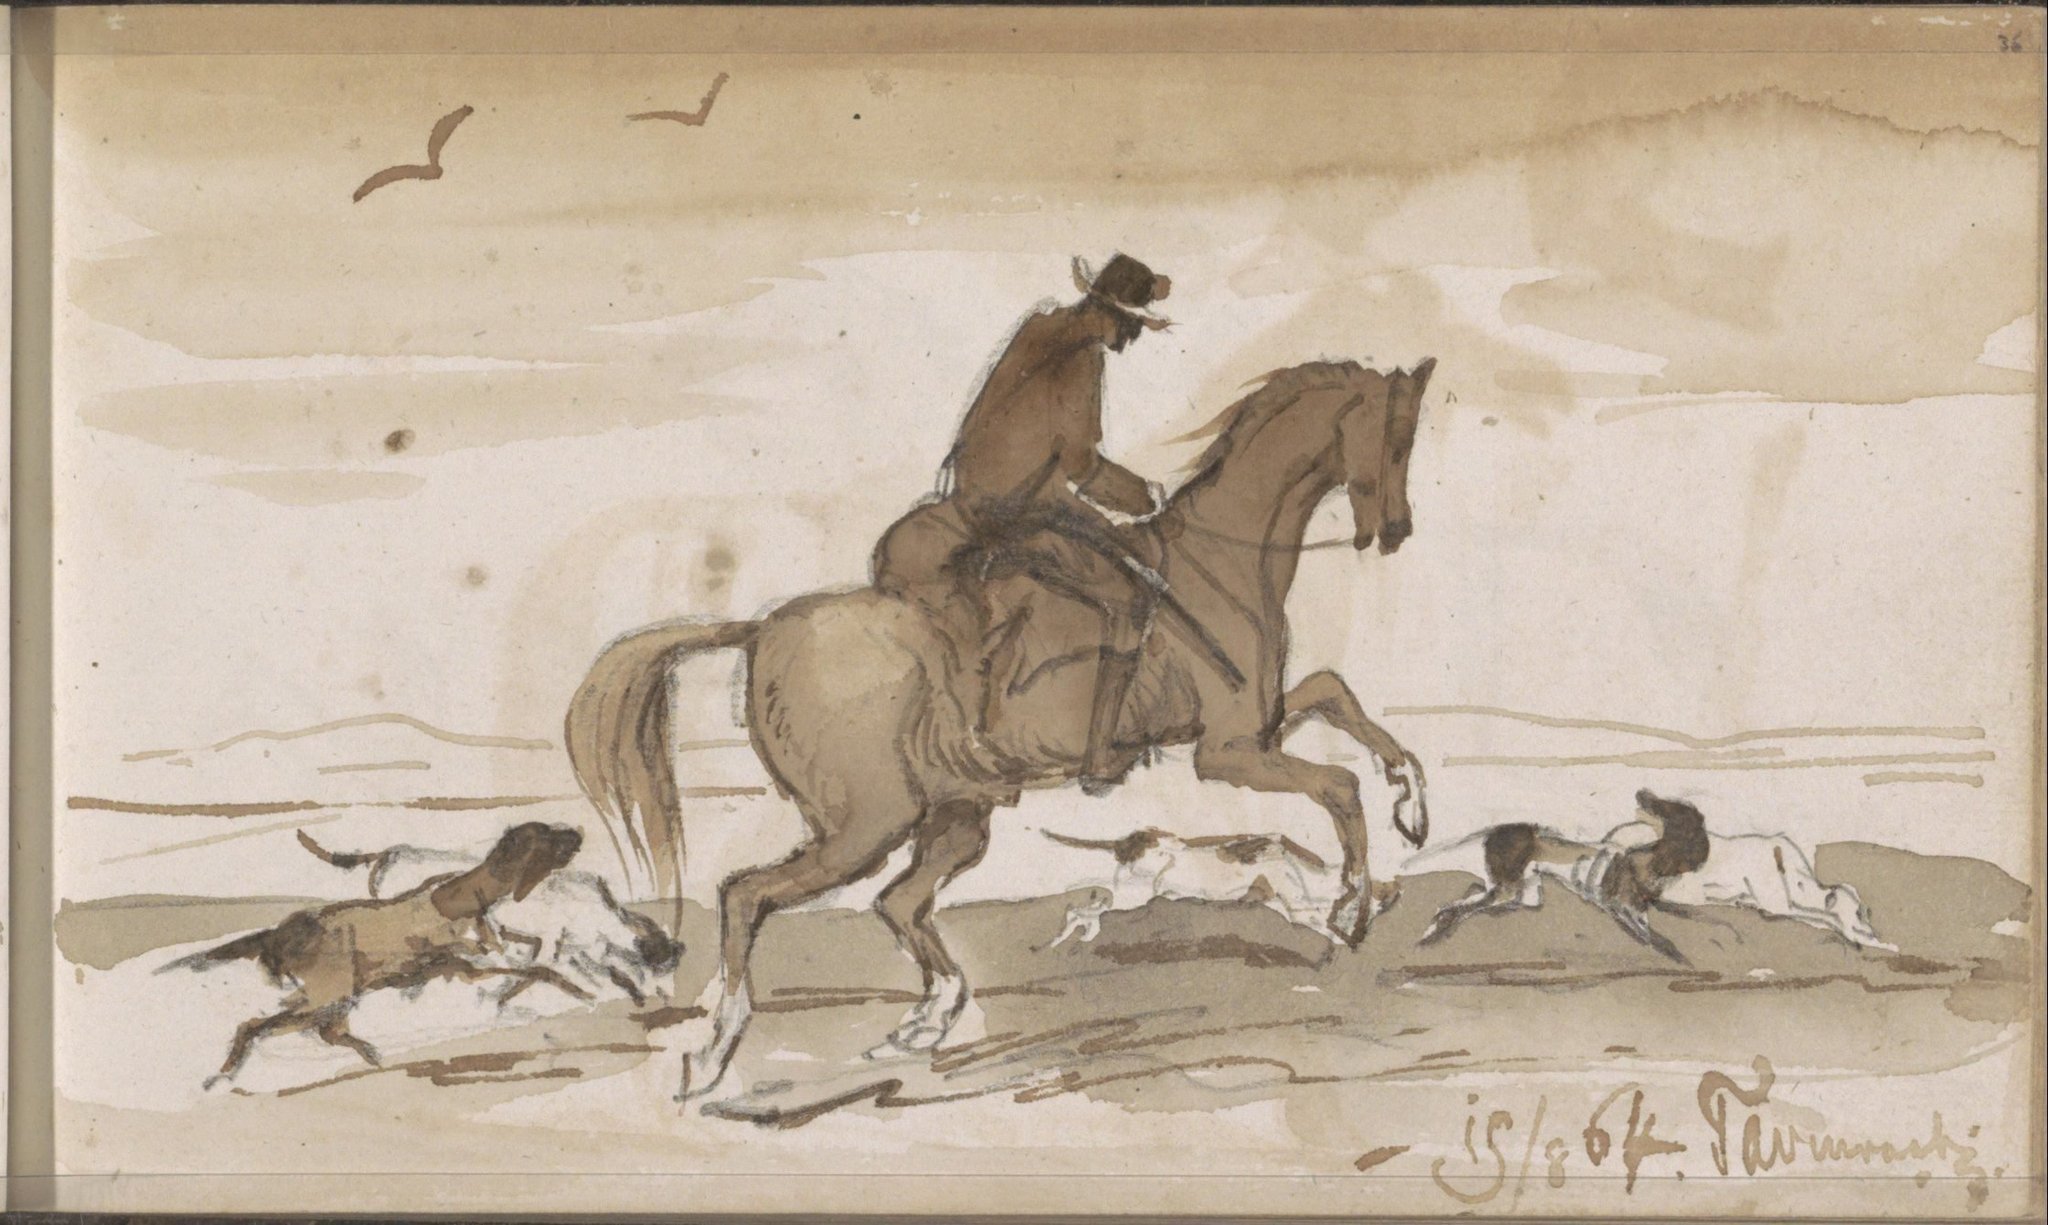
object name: sketchbook leaf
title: Landschap met een ruiter en rennende honden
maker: johannes tavenraat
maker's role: draughtsman, painter, print maker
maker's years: 1809-1881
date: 1808-1864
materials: ink, paper, pencil, watercolor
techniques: brush, pen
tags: riding a horse, ass, or mule; rider, horseman, landscapes, dog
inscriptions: date: ‘15/8 64.’, signature: ‘Tavenraat’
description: Blad 36 recto uit een schetsboek met 98 bladen.